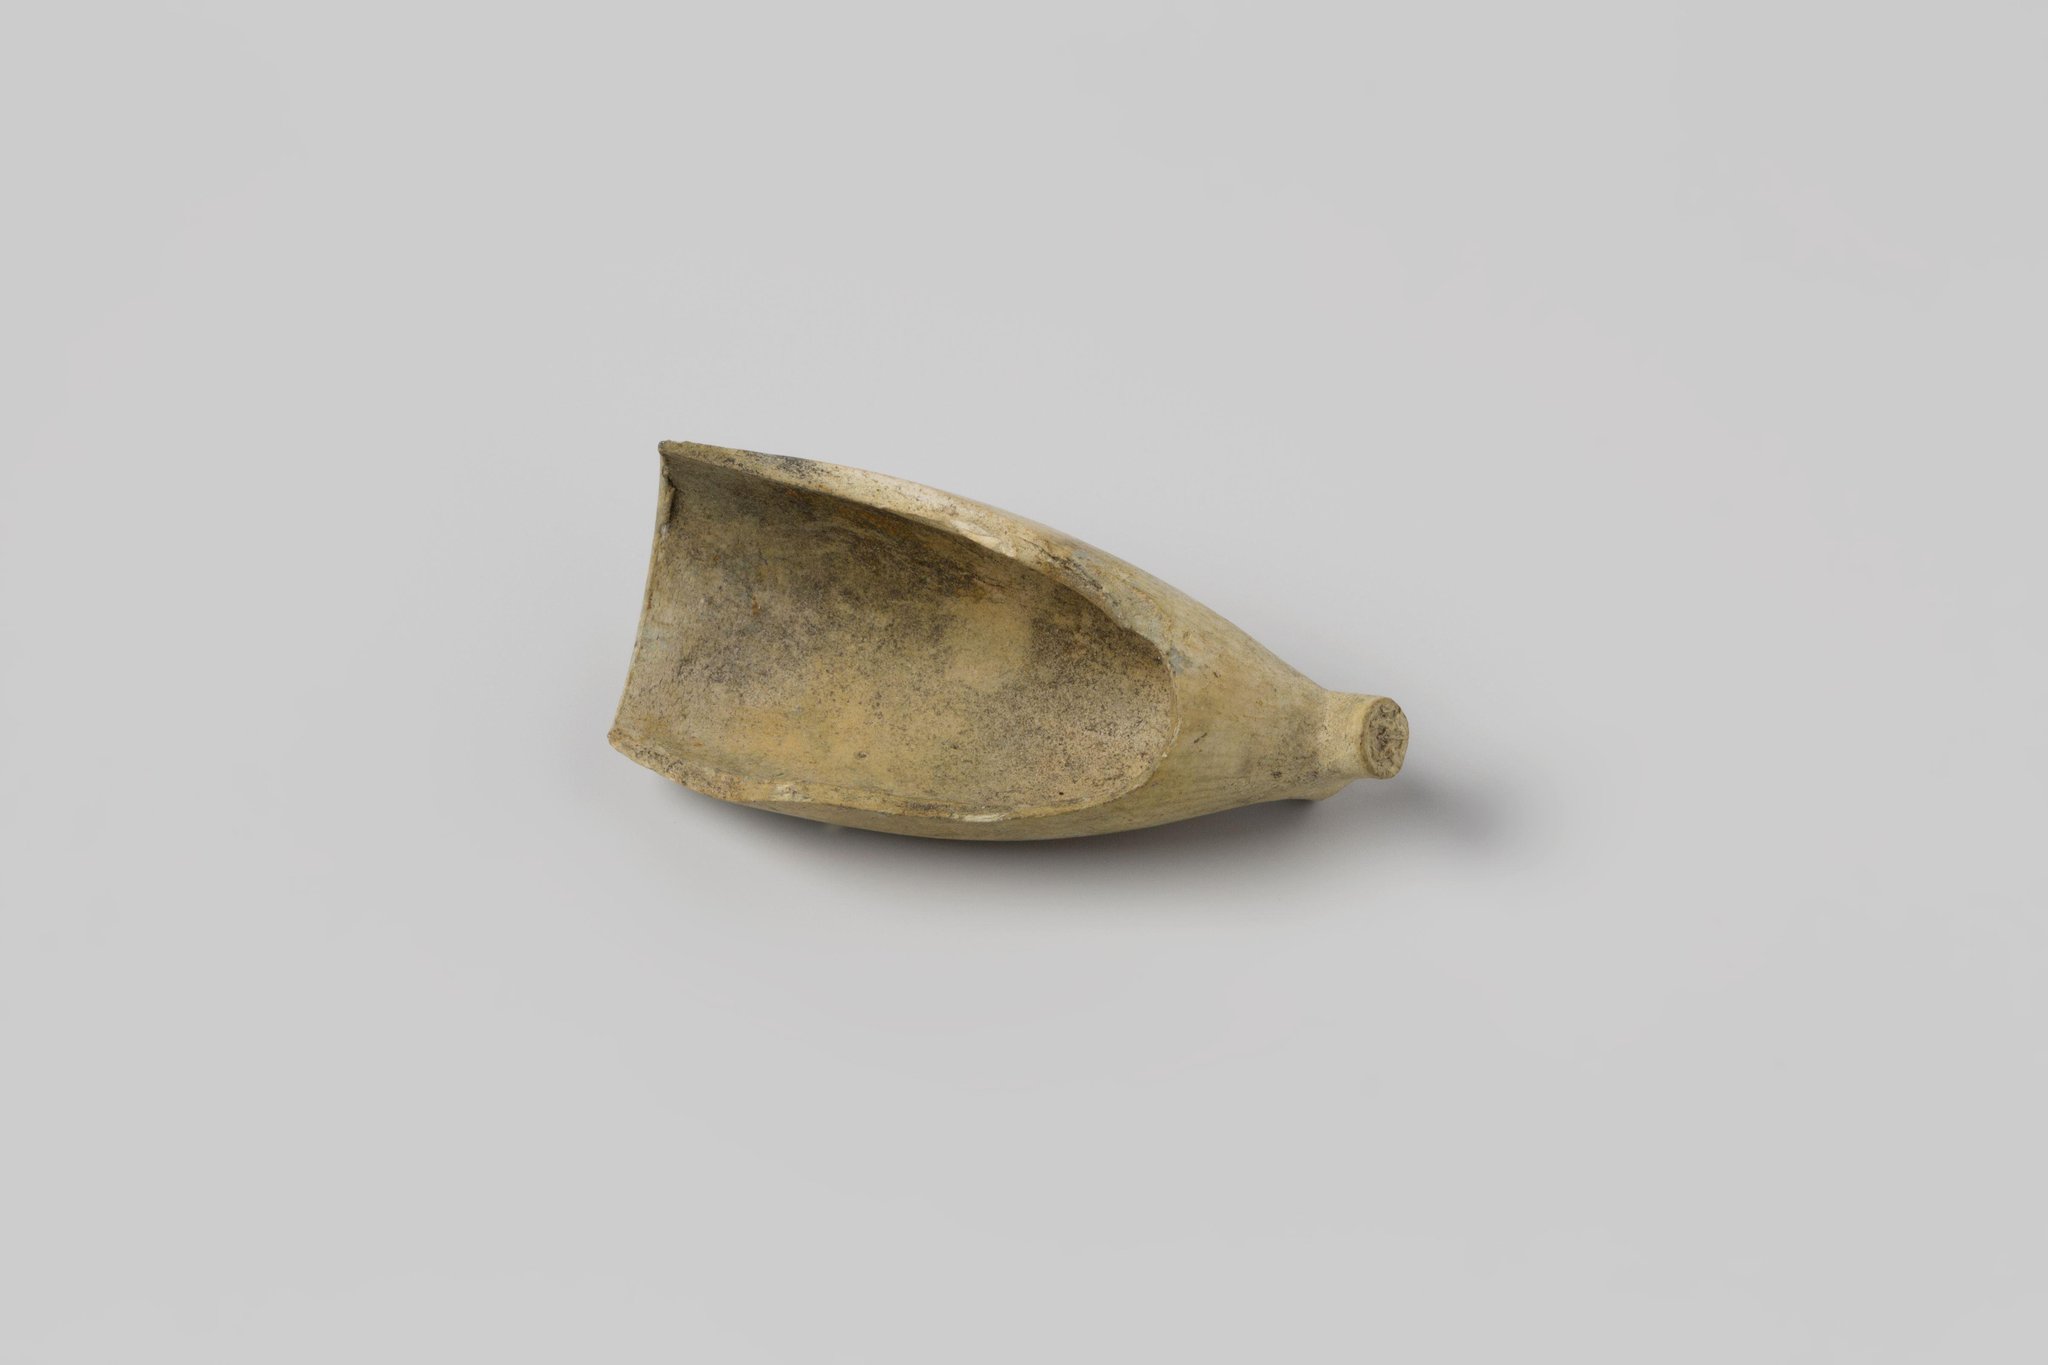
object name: pipe bowl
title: Fragment pijpenkop uit het wrak van de Oost-Indiëvaarder Hollandia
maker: Anonymous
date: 1700-1743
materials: clay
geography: netherlands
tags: verenigde oostindische compagnie, hollandia (schip), annet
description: Pipe, bowl, heelmark: coat of arms of the province of Gelderland; fragm, no hsm.